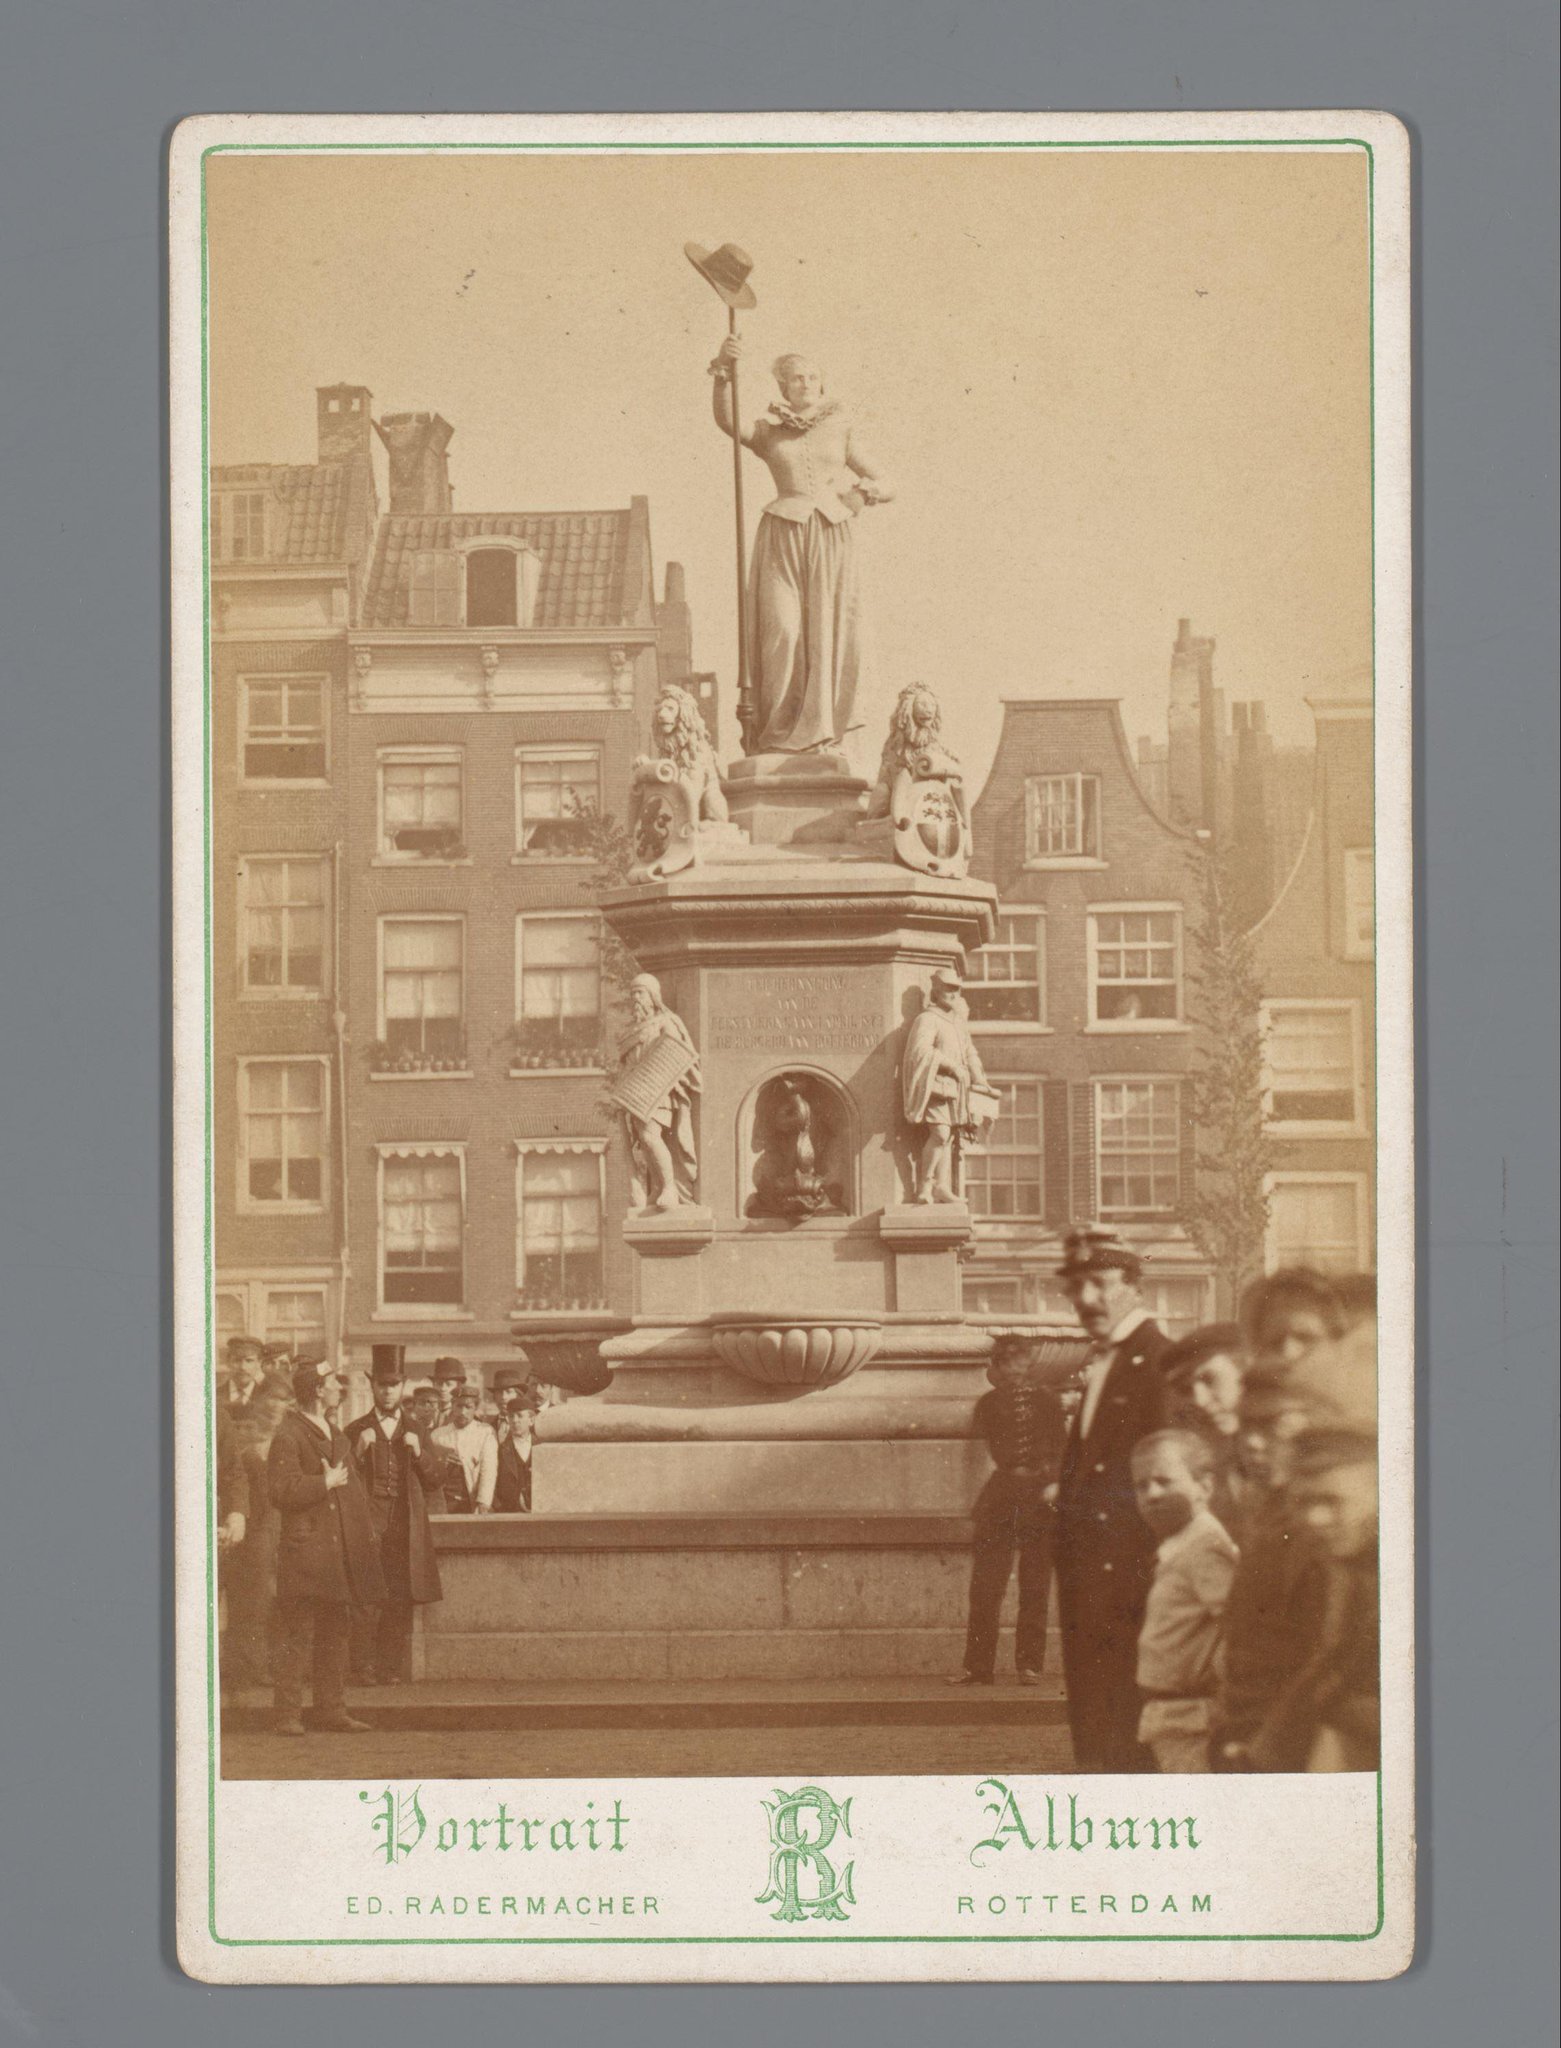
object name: photograph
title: Gezicht op het Monument 1872 op de Nieuwemarkt te Rotterdam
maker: ed. radermacher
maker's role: fotograaf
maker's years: 1839-1908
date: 1874-1893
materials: cardboard, photographic support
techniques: albumen print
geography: rotterdam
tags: monument, statue, rotterdam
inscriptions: annotation: ‘Rotterdam’, inscription: ‘Portrait/ Ed. Radermacher/ Album Rotterdam’